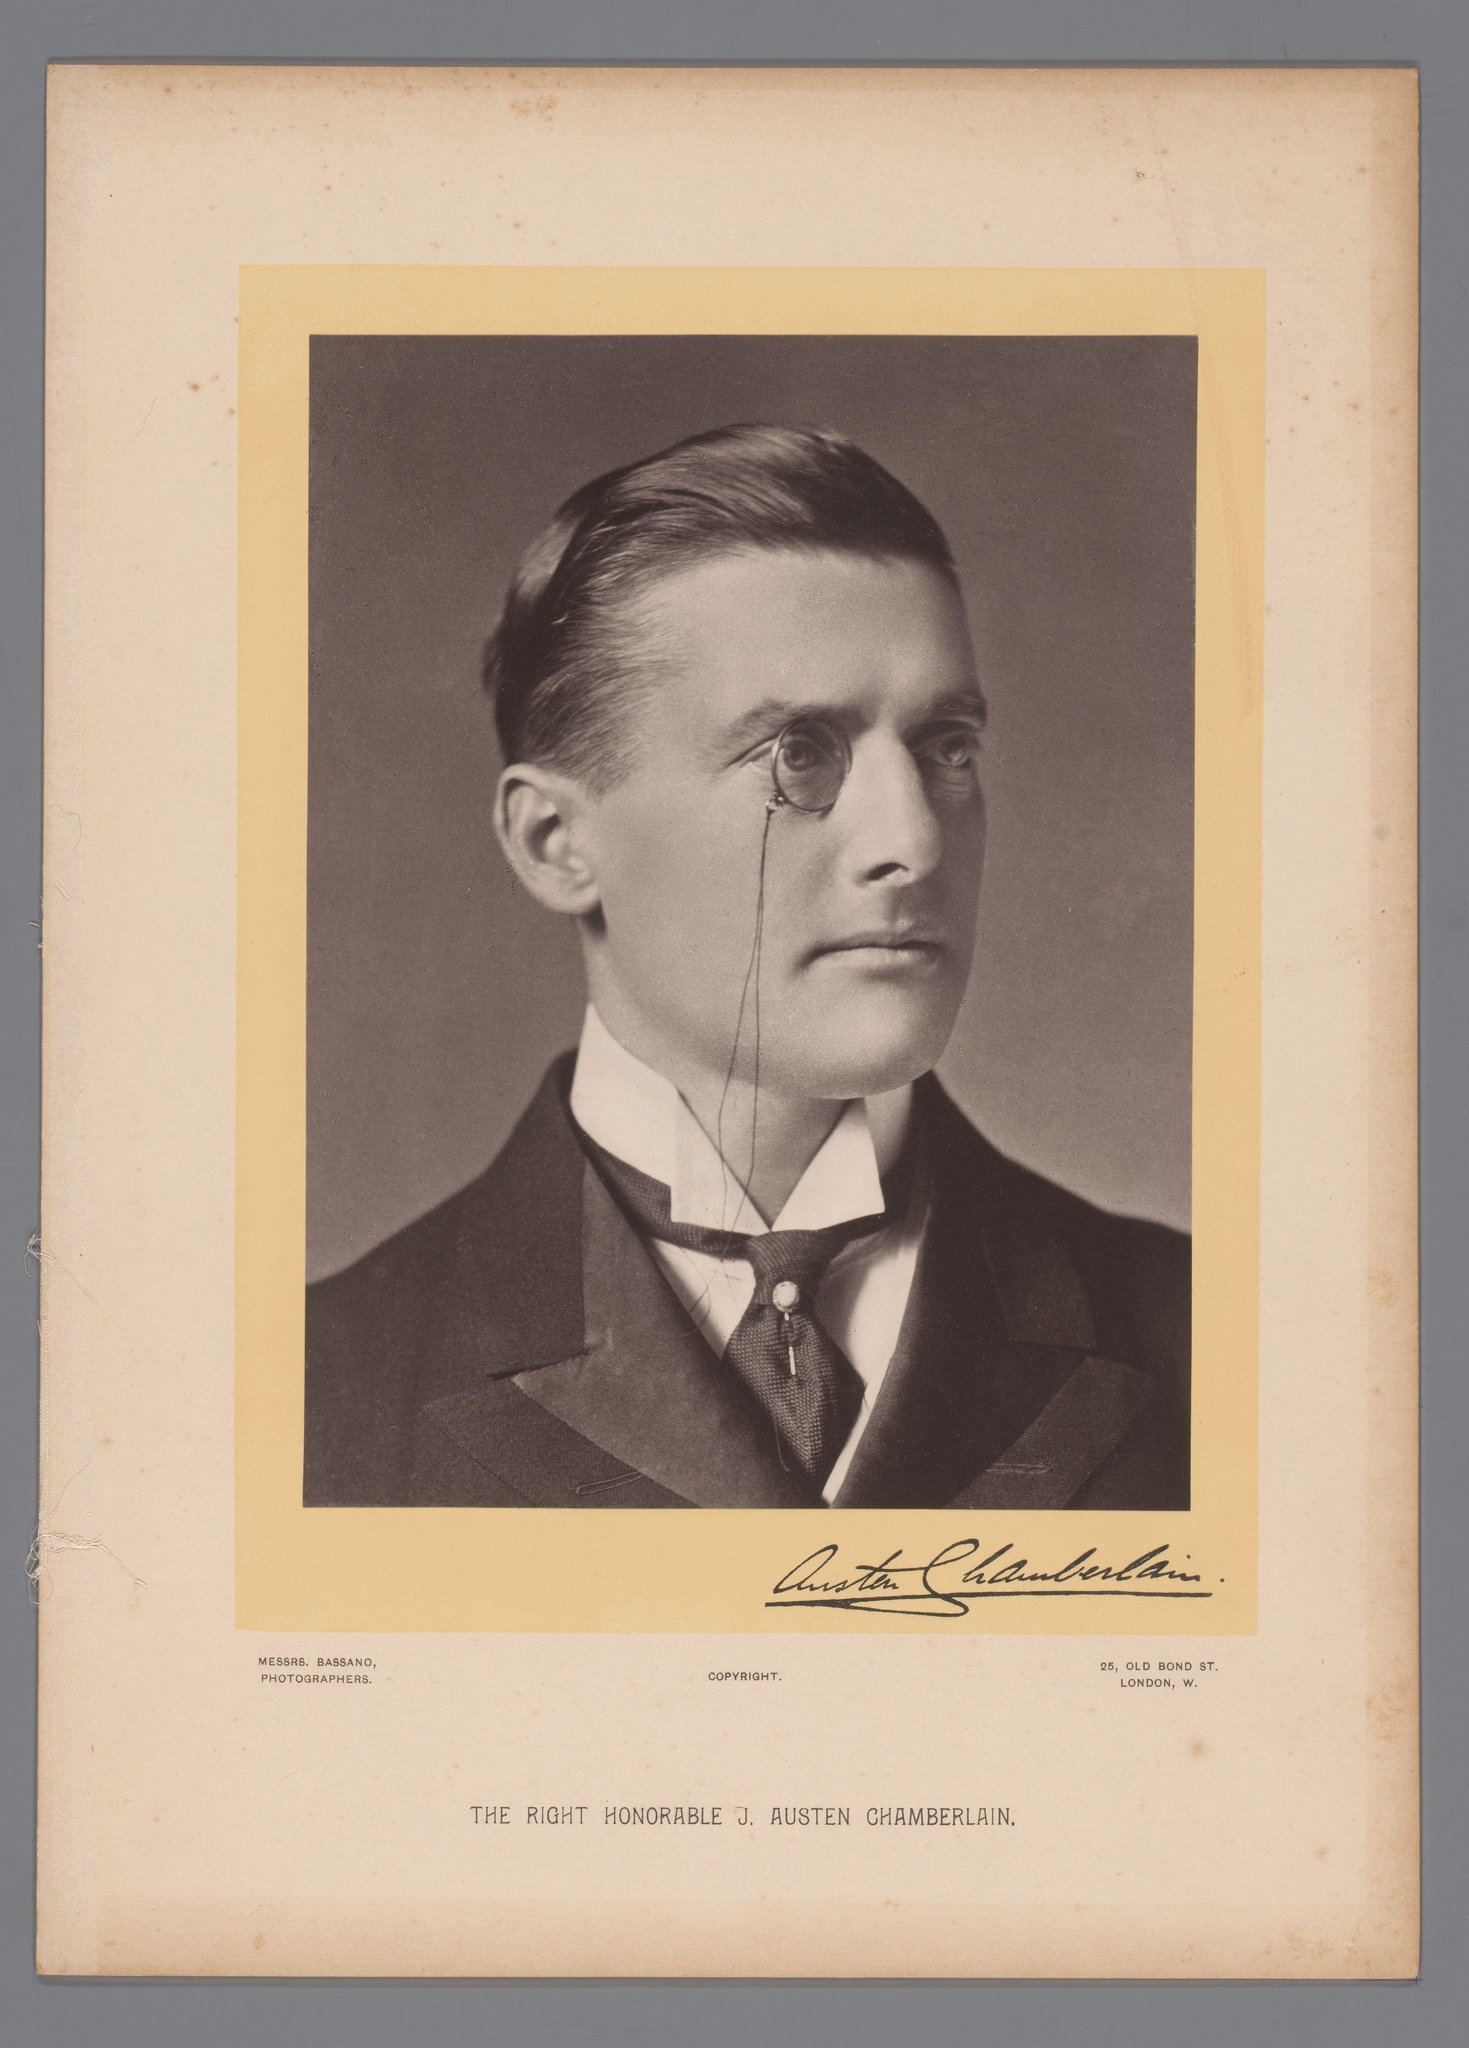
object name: photograph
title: J. Austen Chamberlain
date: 1876-1921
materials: cardboard, paper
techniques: carbon print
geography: london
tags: birmingham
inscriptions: caption: ‘The Right Honorable J. Austen Chamberlain.’, caption: ‘Austen Chamberlain’, caption: ‘Messrs. Bassano,//Photographers//Copyright//25 Old Bond St.//London, W.’